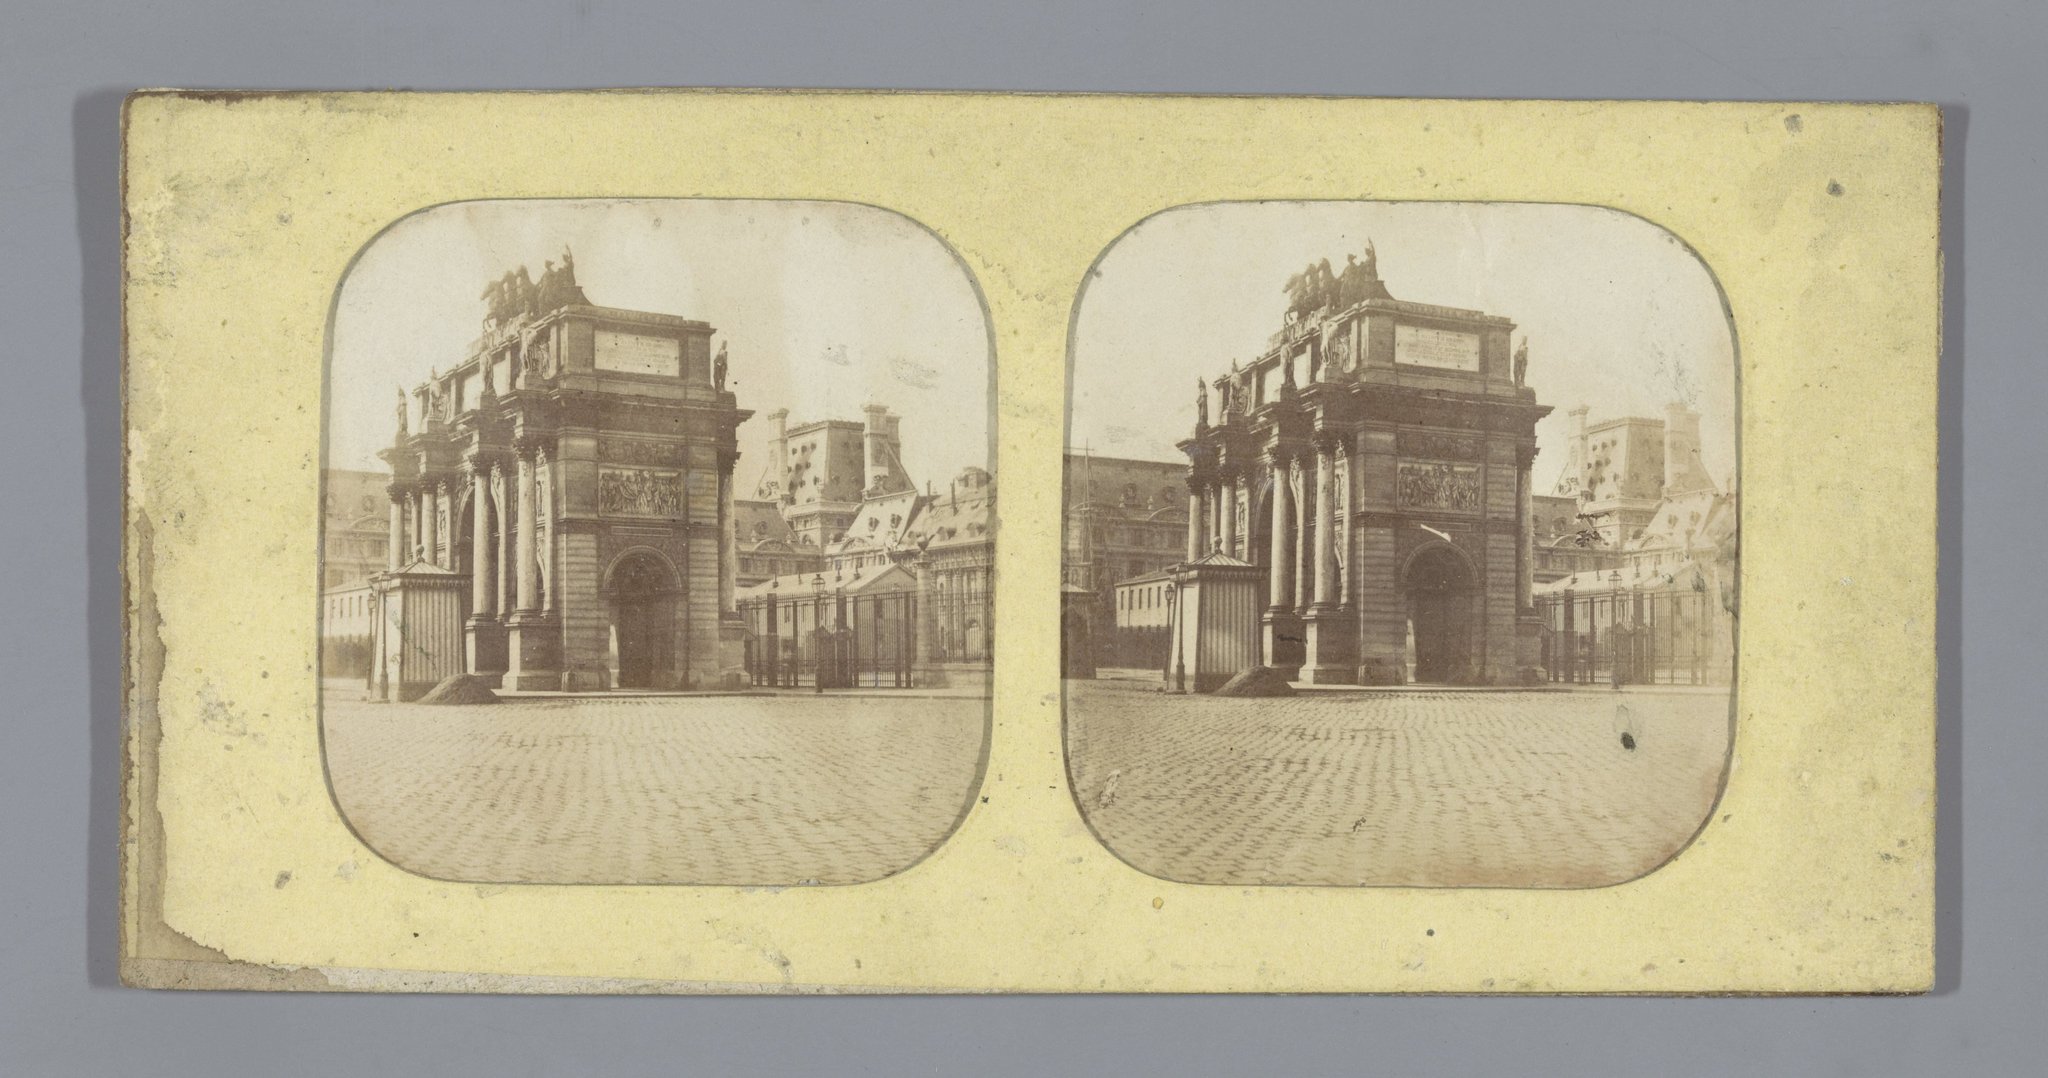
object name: tissue stereograph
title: Arc de Triomphe du Carrousel voor het Tuilerieënpaleis, Parijs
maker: Anonymous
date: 1855-1871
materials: cardboard, paper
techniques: albumen print, hand coloring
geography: paris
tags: triumphal arch